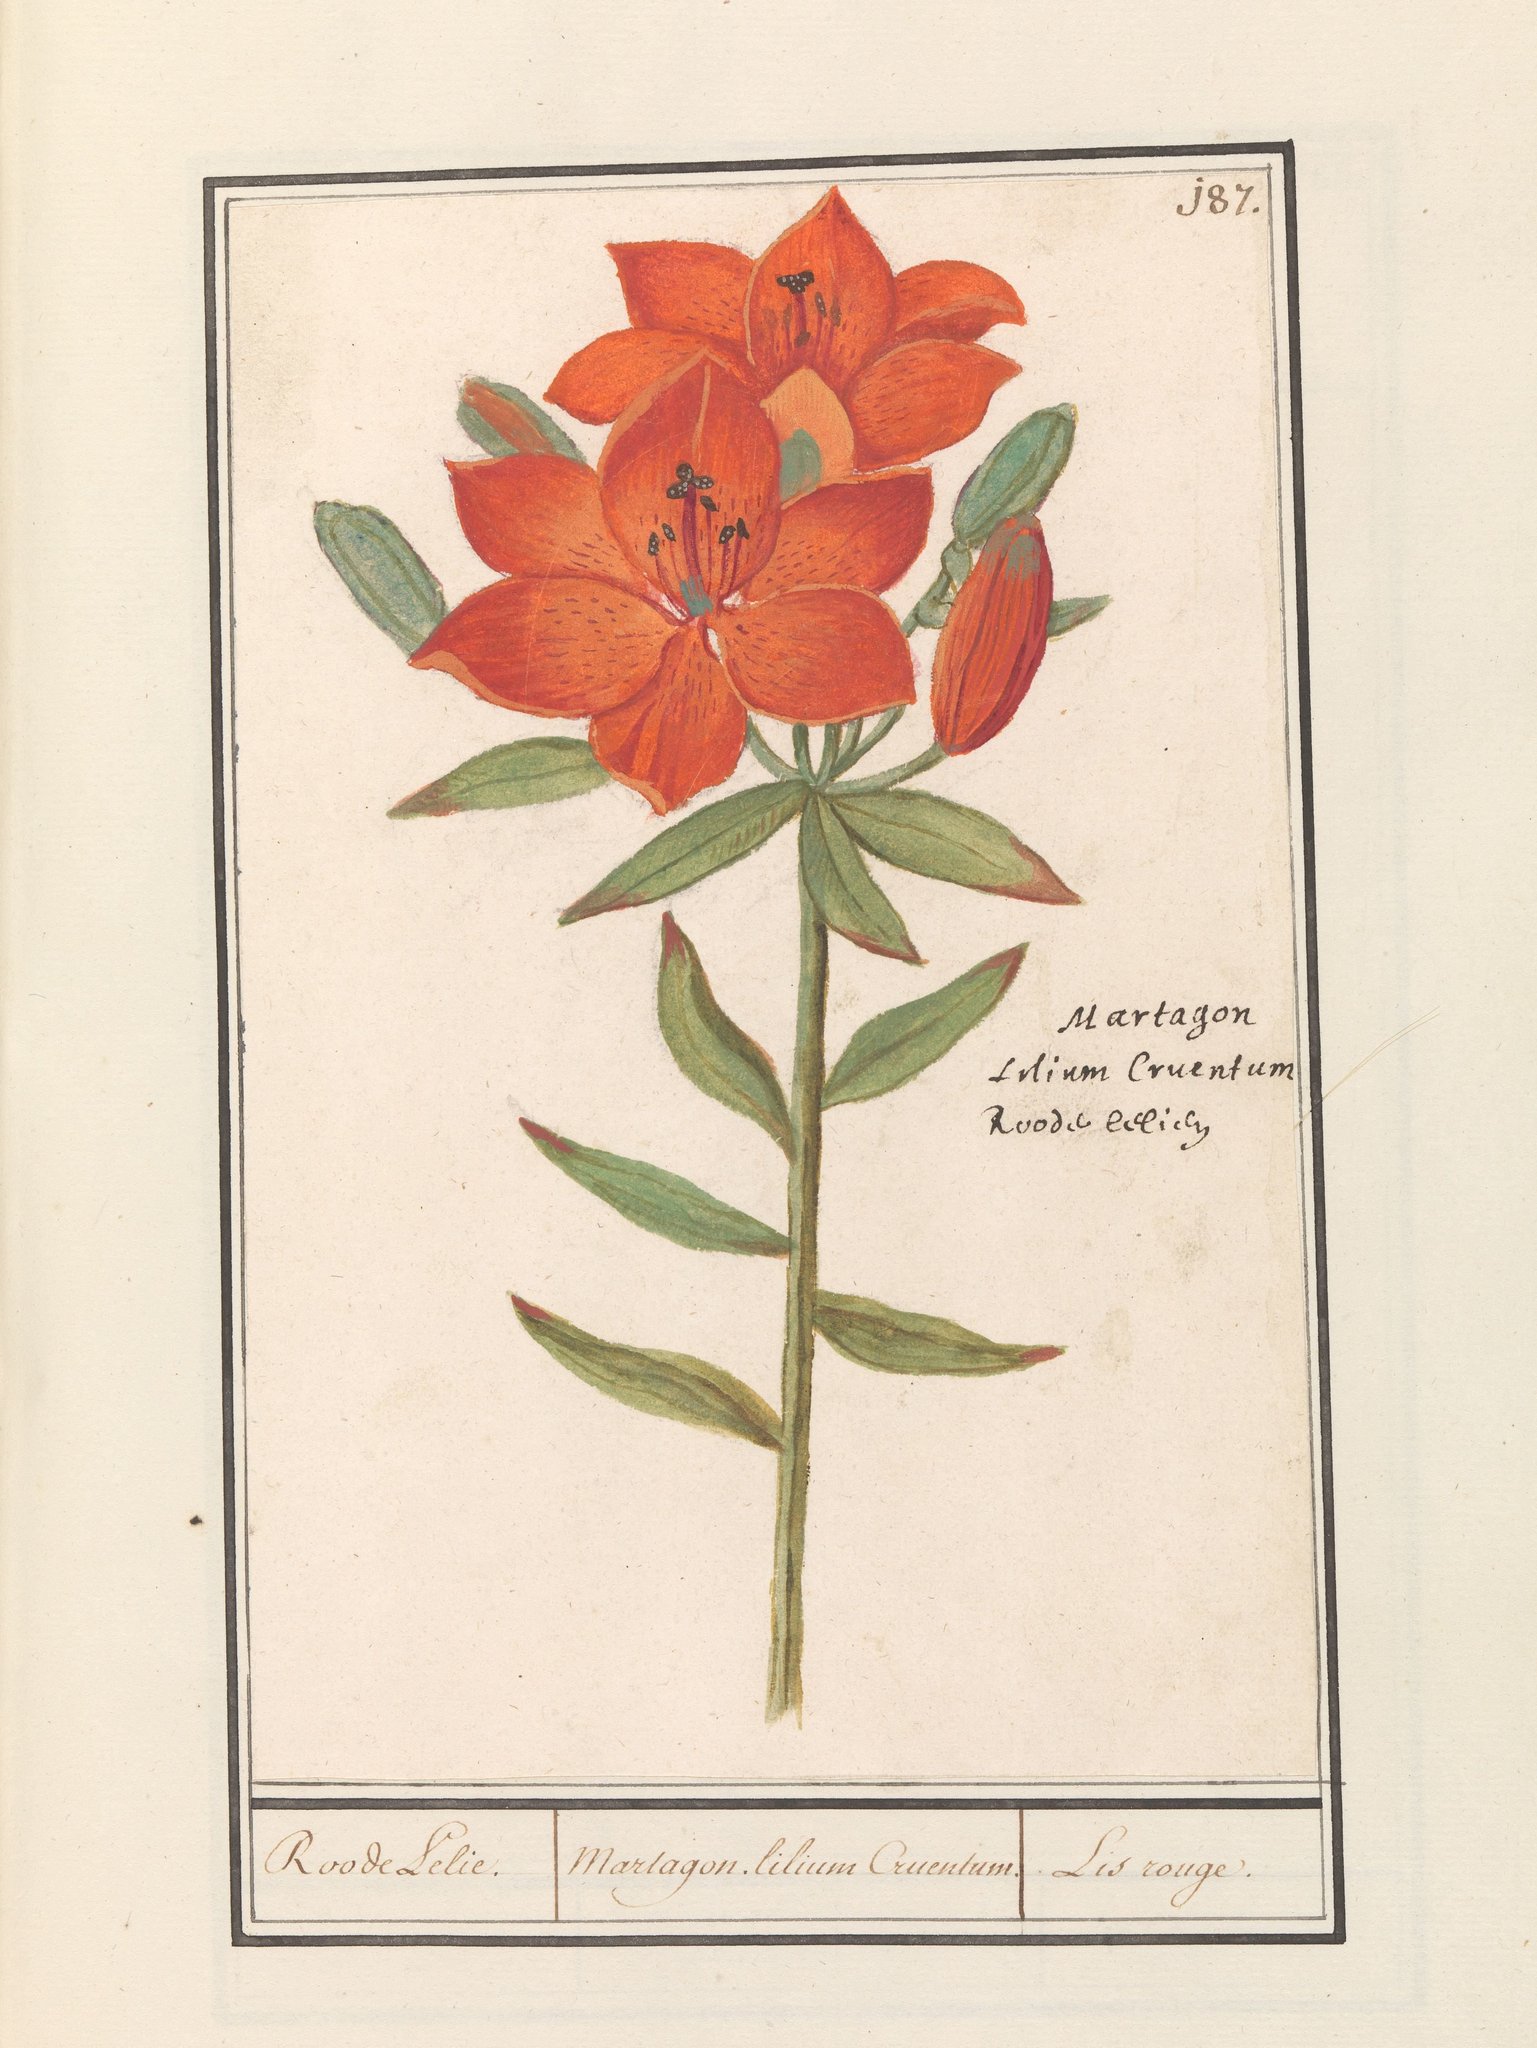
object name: drawing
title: Rode lelie (Lilium)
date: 1596-1610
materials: chalk, paint, ink, paper, watercolor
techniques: brush, pen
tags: flowers: lily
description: Oranjerode lelie. Rechtsboven genummerd: 187. Rechts de Latijnse en Nederlandse naam. Onderdeel van het tweede album met tekeningen van bloemen en planten. Negende van twaalf albums met tekeningen van dieren, vogels en planten bekend rond 1600, gemaakt in opdracht van keizer Rudolf II. Met toelichting in Nederlands, Latijn en Frans.